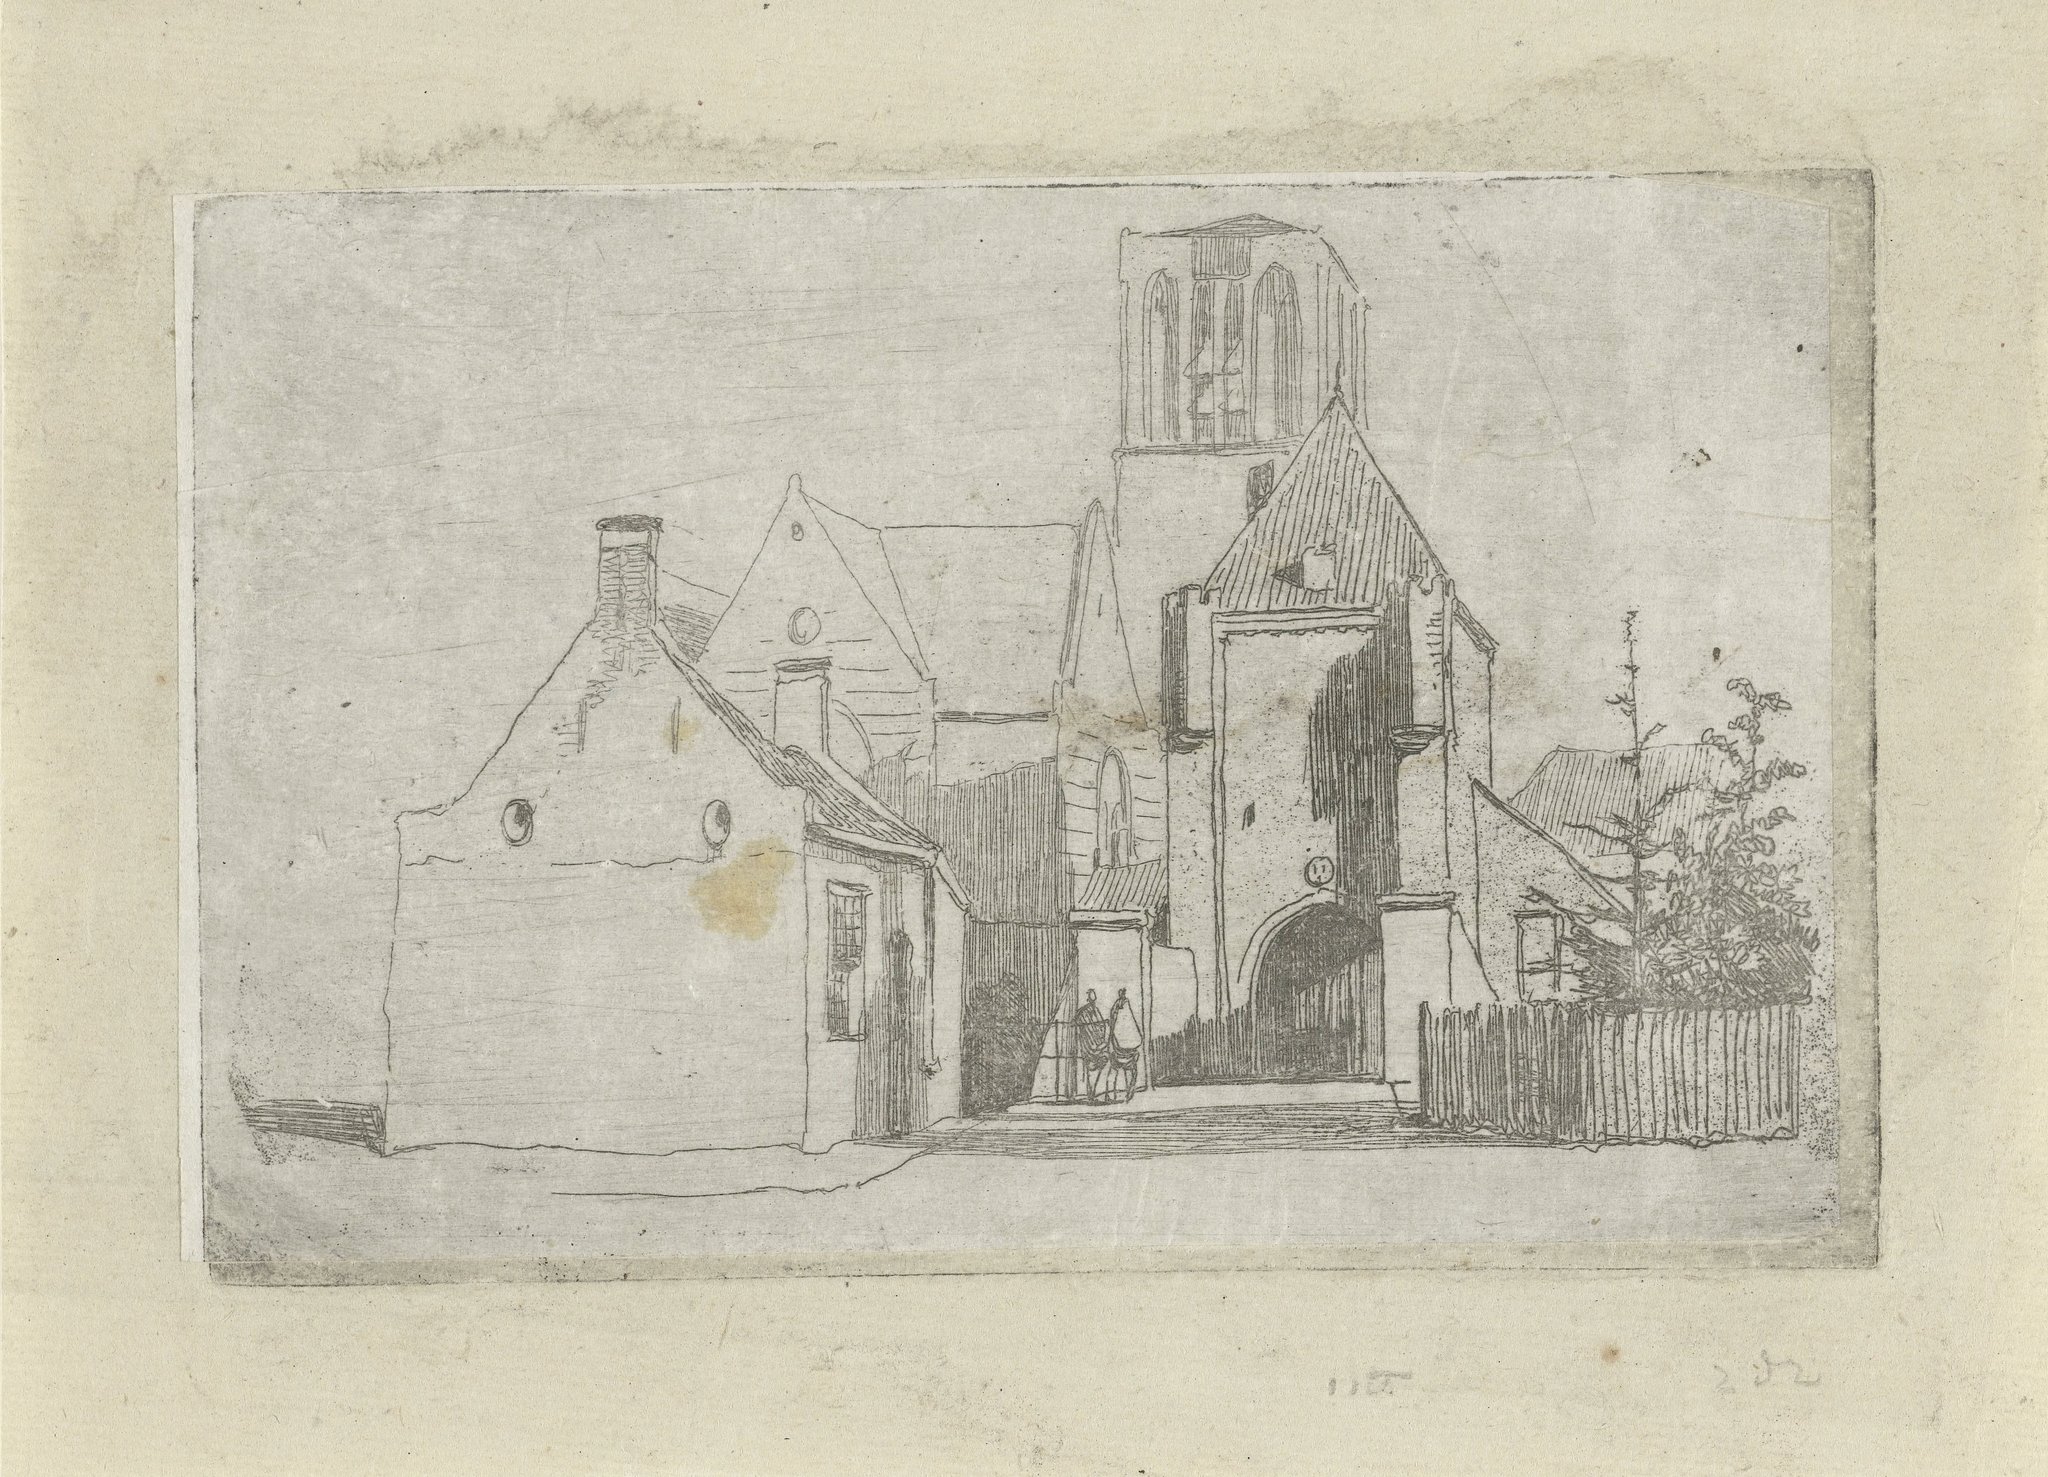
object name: print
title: Kerk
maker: lambertus hardenberg (1822-1900)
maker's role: draughtsman, painter, print maker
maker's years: 1822-1900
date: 1837-1900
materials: paper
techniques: etching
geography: the hague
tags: church (exterior)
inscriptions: collector's mark: Lugt 2228